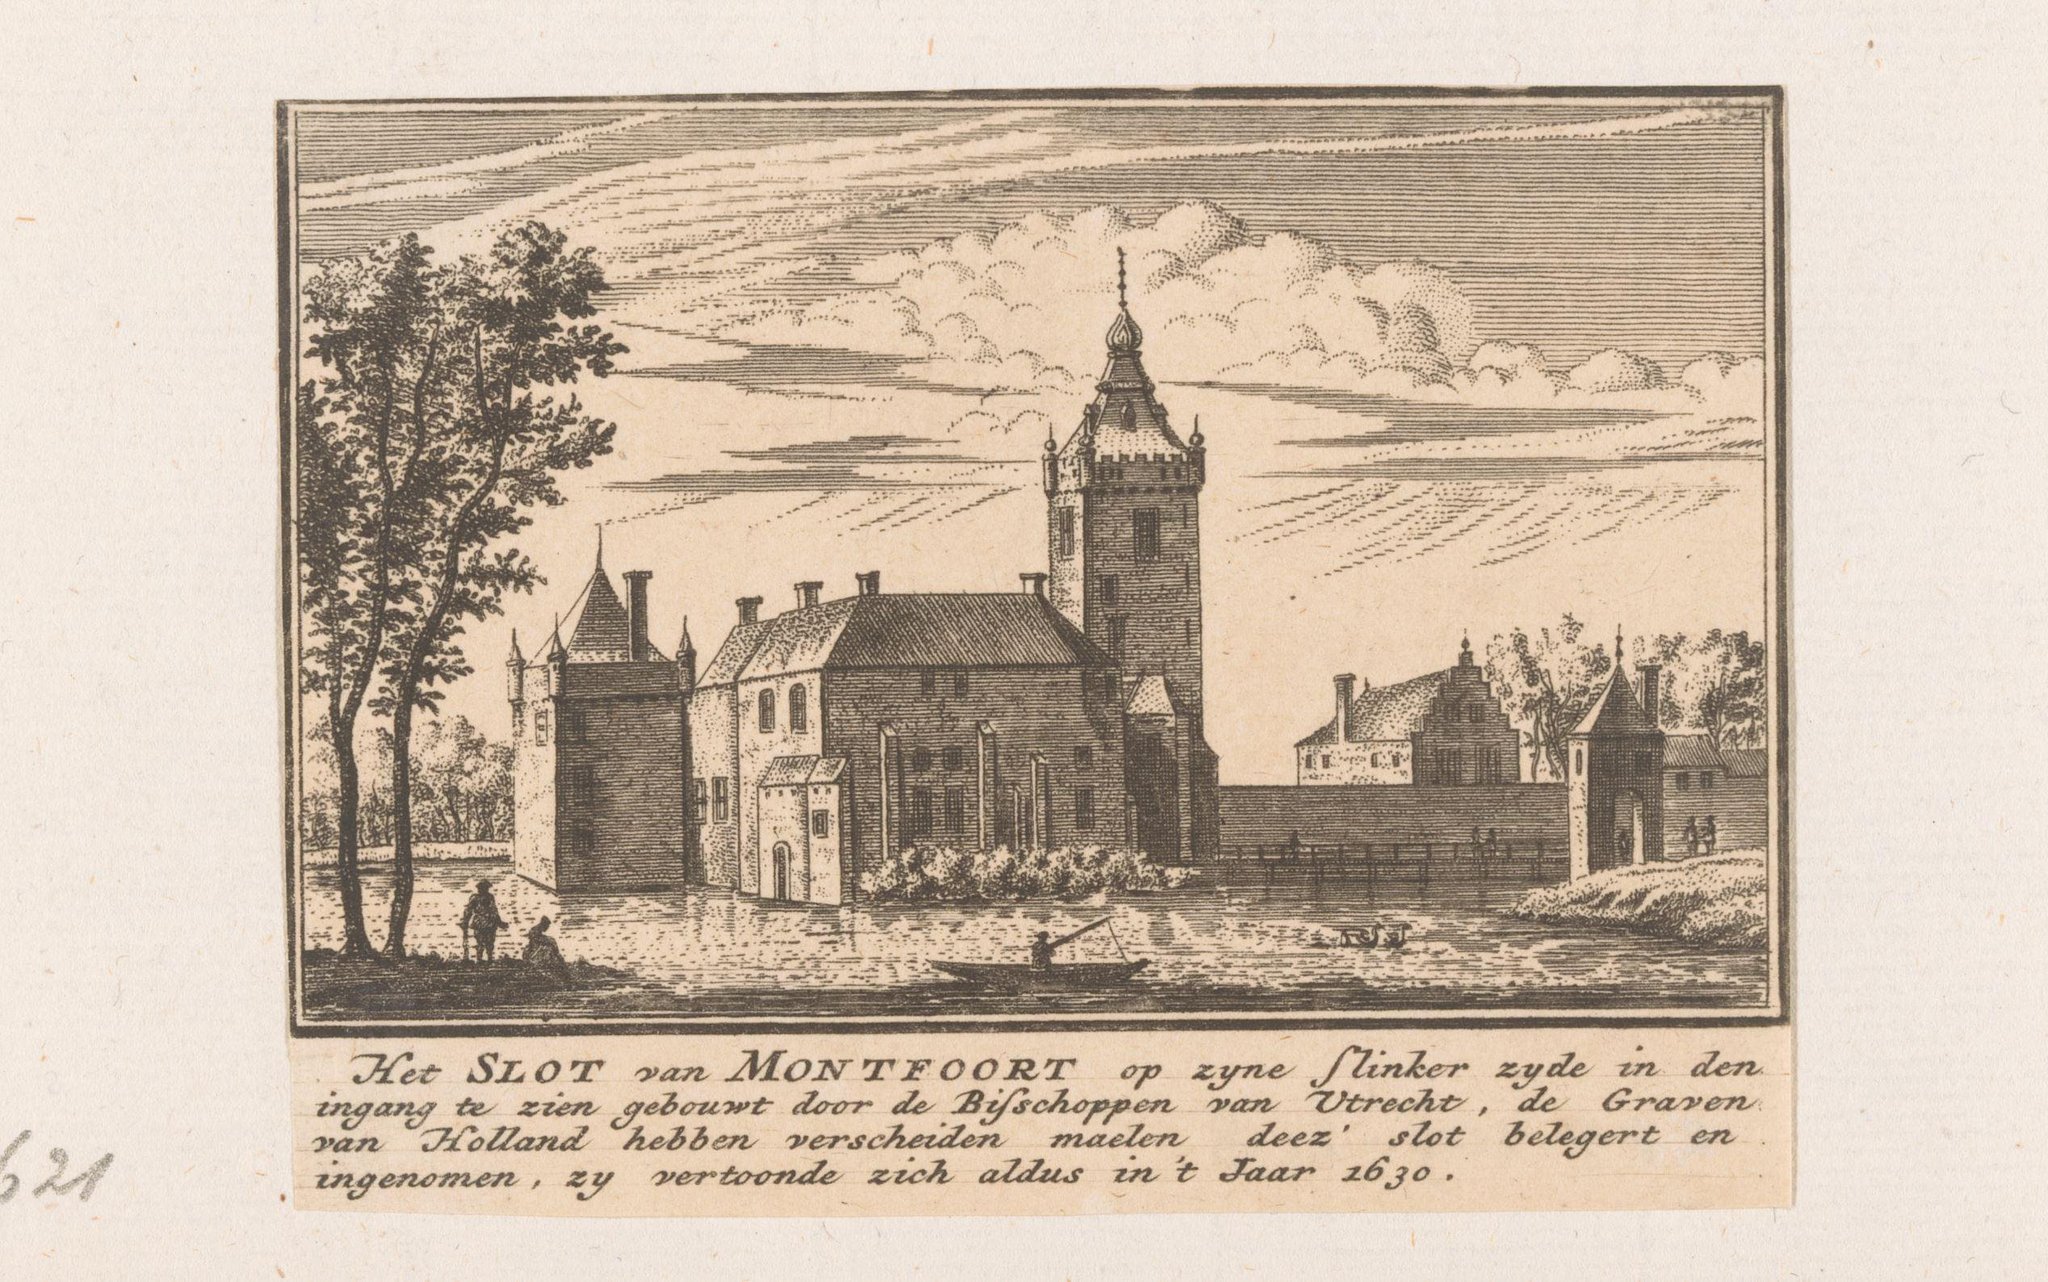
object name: print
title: Gezicht op het kasteel te Montfoort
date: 1726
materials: paper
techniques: etching, letterpress printing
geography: northern netherlands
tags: castle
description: Prent uit: Rademaker, Abraham. Versameling van 100. Nederlantse Outheden en Gesigten / Versameling van 100 Nederlantsche outheden en gesigten. Amsterdam: Isaac Greve, [ca. 1726].